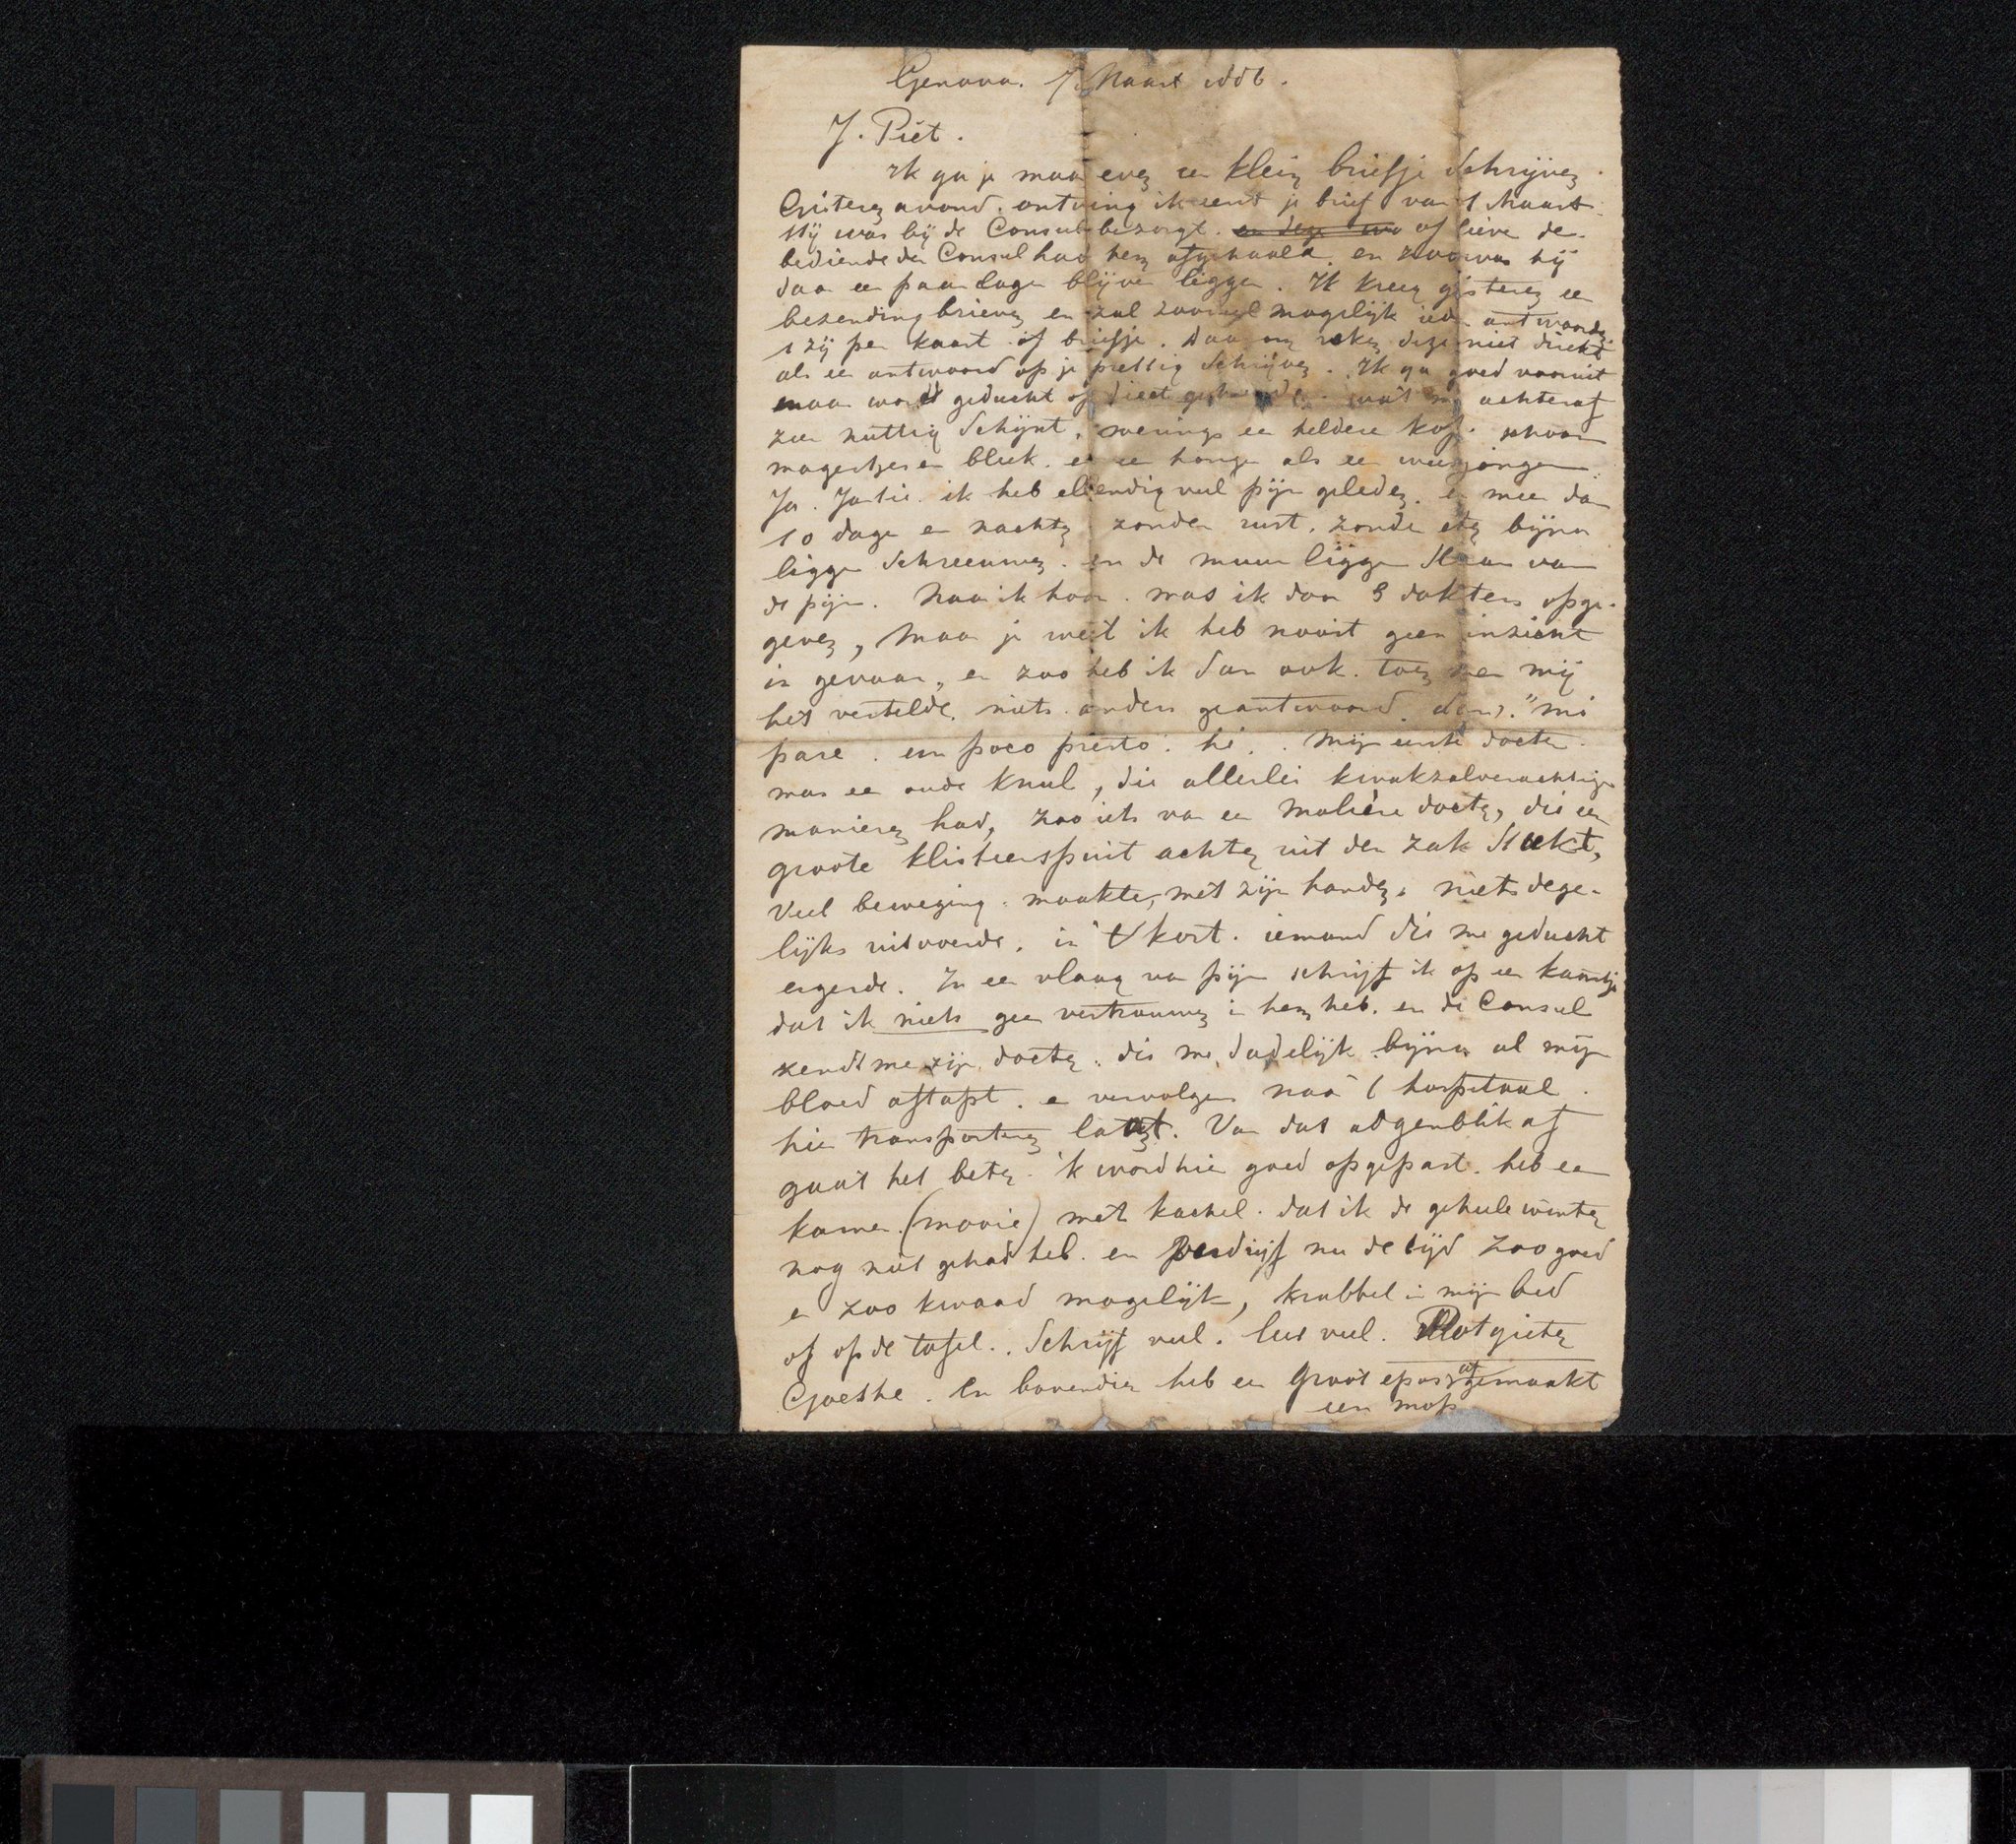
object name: letter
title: Brief aan Jan Veth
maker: jac van looij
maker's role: draughtsman, painter, print maker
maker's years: 1855-1930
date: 1886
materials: ink, paper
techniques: pen, writing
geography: genoa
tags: august allebé, designer, jan veth, willem witsen, everhardus johannes potgieter, johann wolfgang von goethe, the hague, willem kloos, dordrecht, amsterdam, chap van deventer, drawing, diseases, venice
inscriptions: collector's mark: ‘RPK’